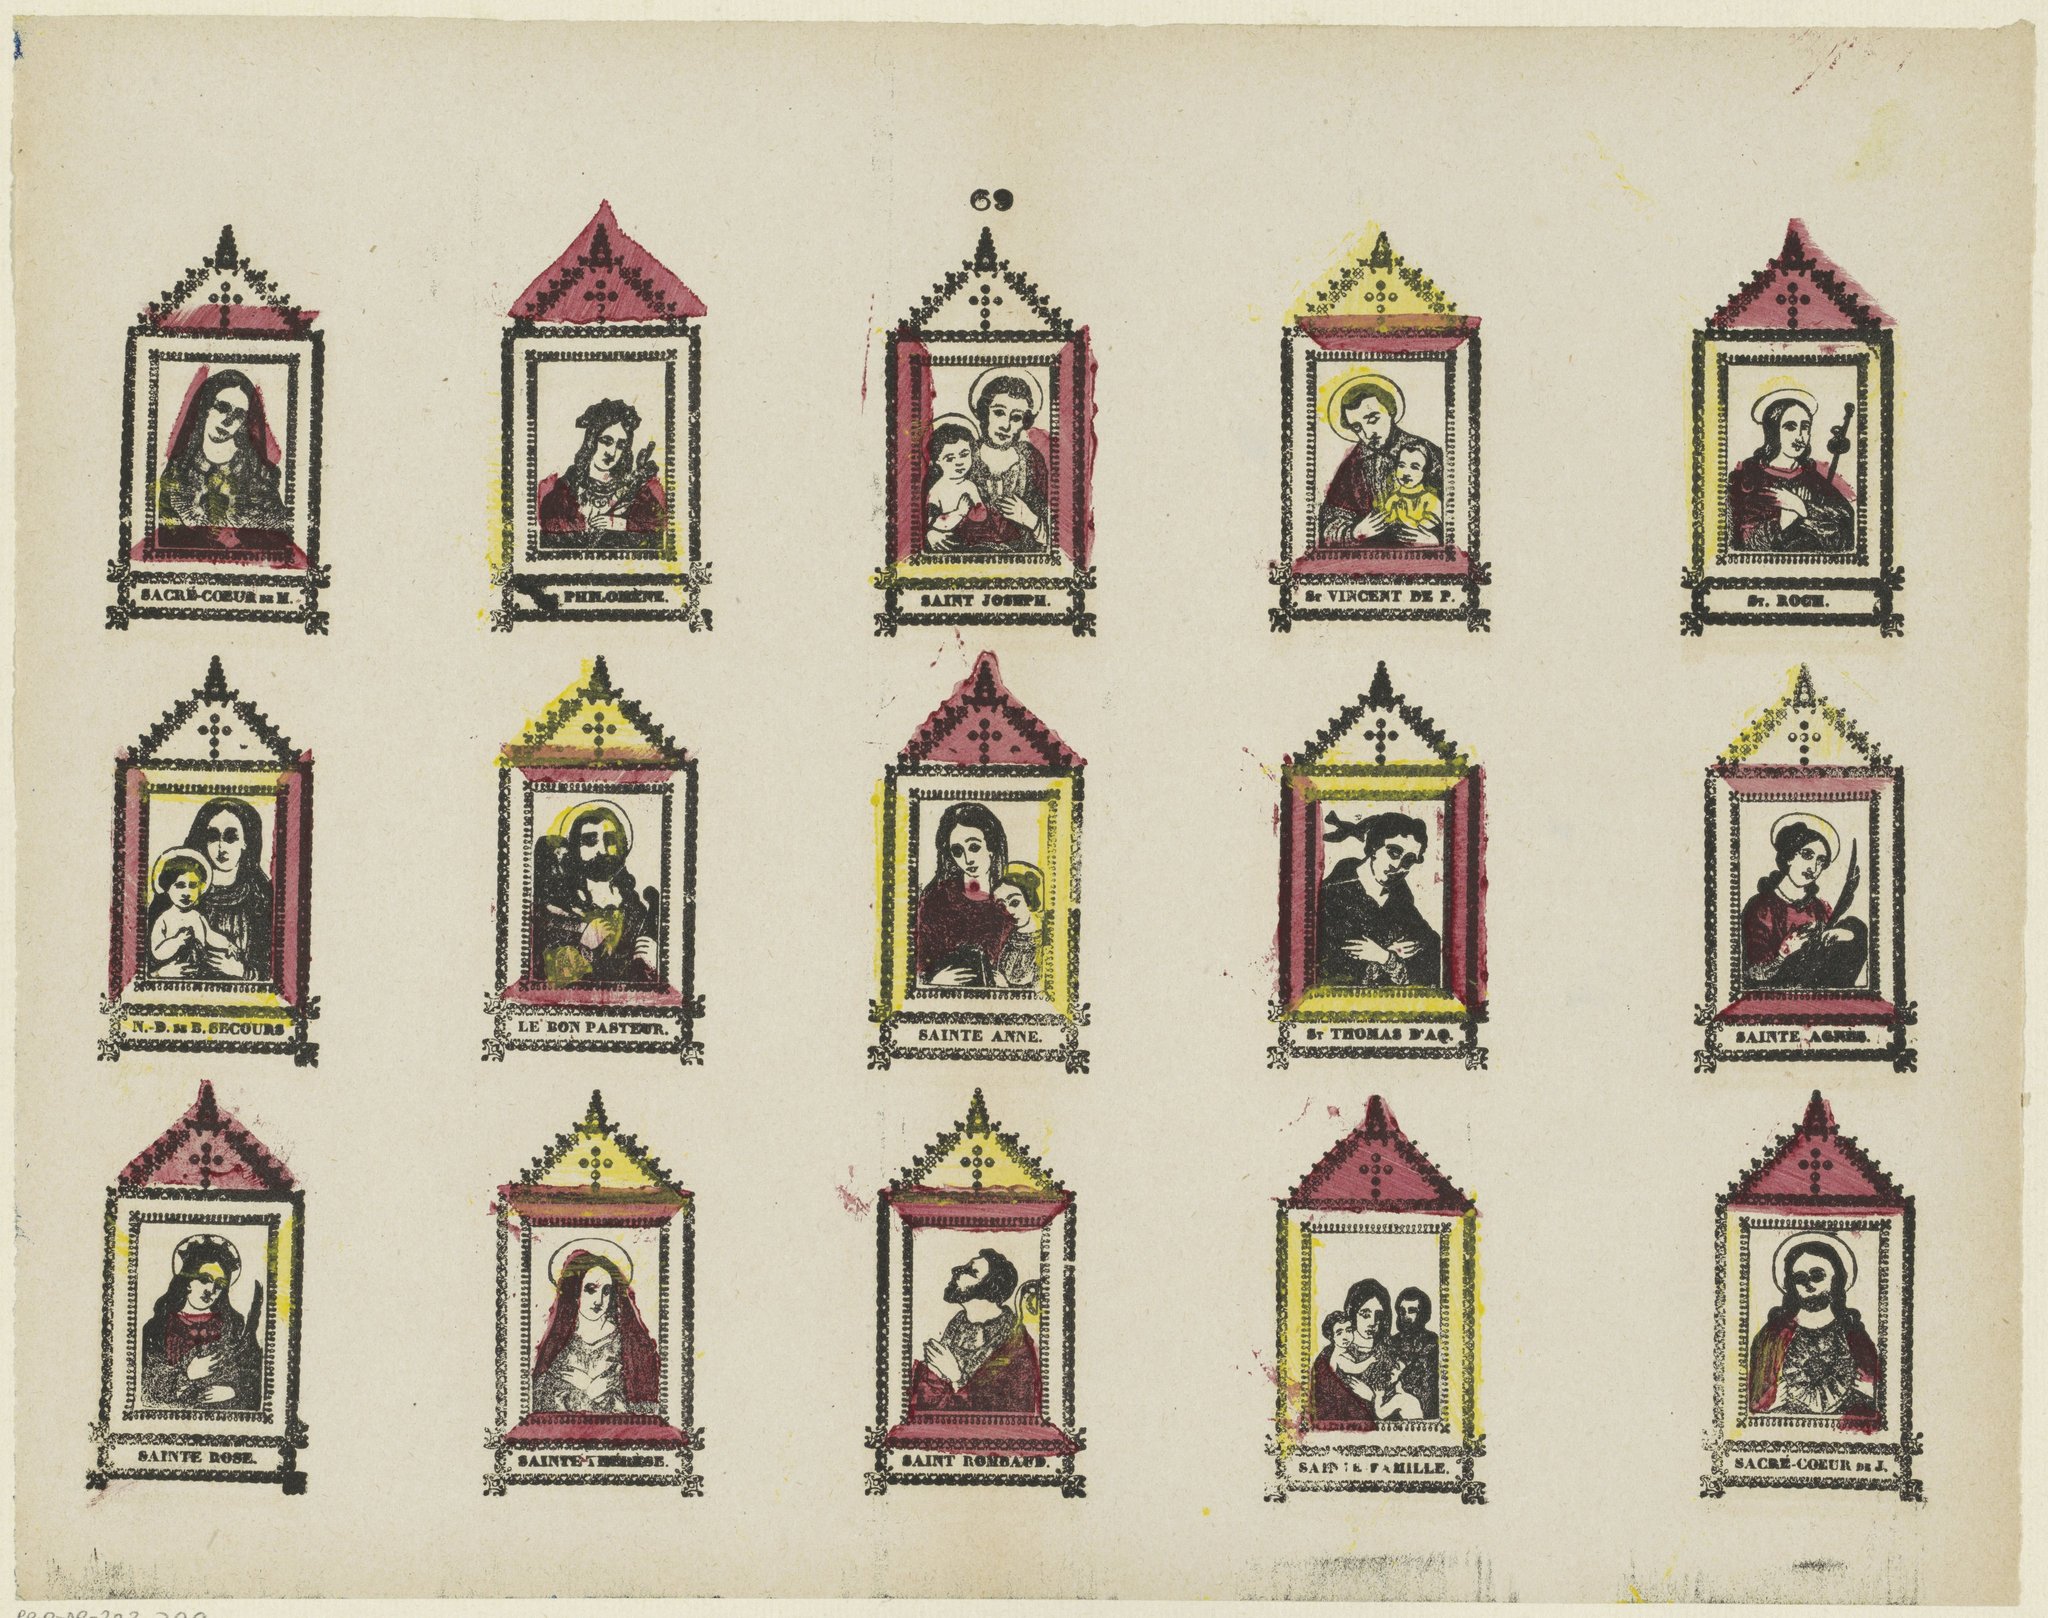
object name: print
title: Bidprentjes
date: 1827-1894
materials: paper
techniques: colour, letterpress printing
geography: schaarbeek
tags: saints, female saints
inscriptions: collector's mark: Lugt 2760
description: Blad met 15 bidprentjes met voorstellingen van heiligen in een sierlijst, met onderin telkens de naam van de heilige. Genummerd midden boven: 69.